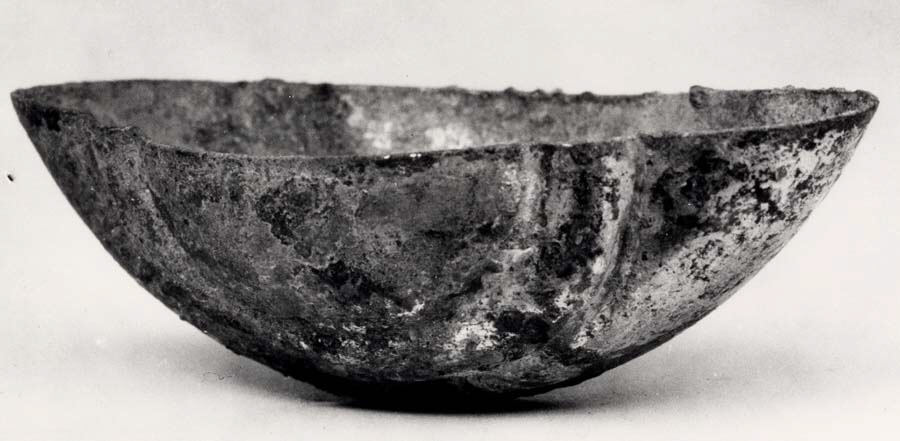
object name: cup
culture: korean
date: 918-1392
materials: silver